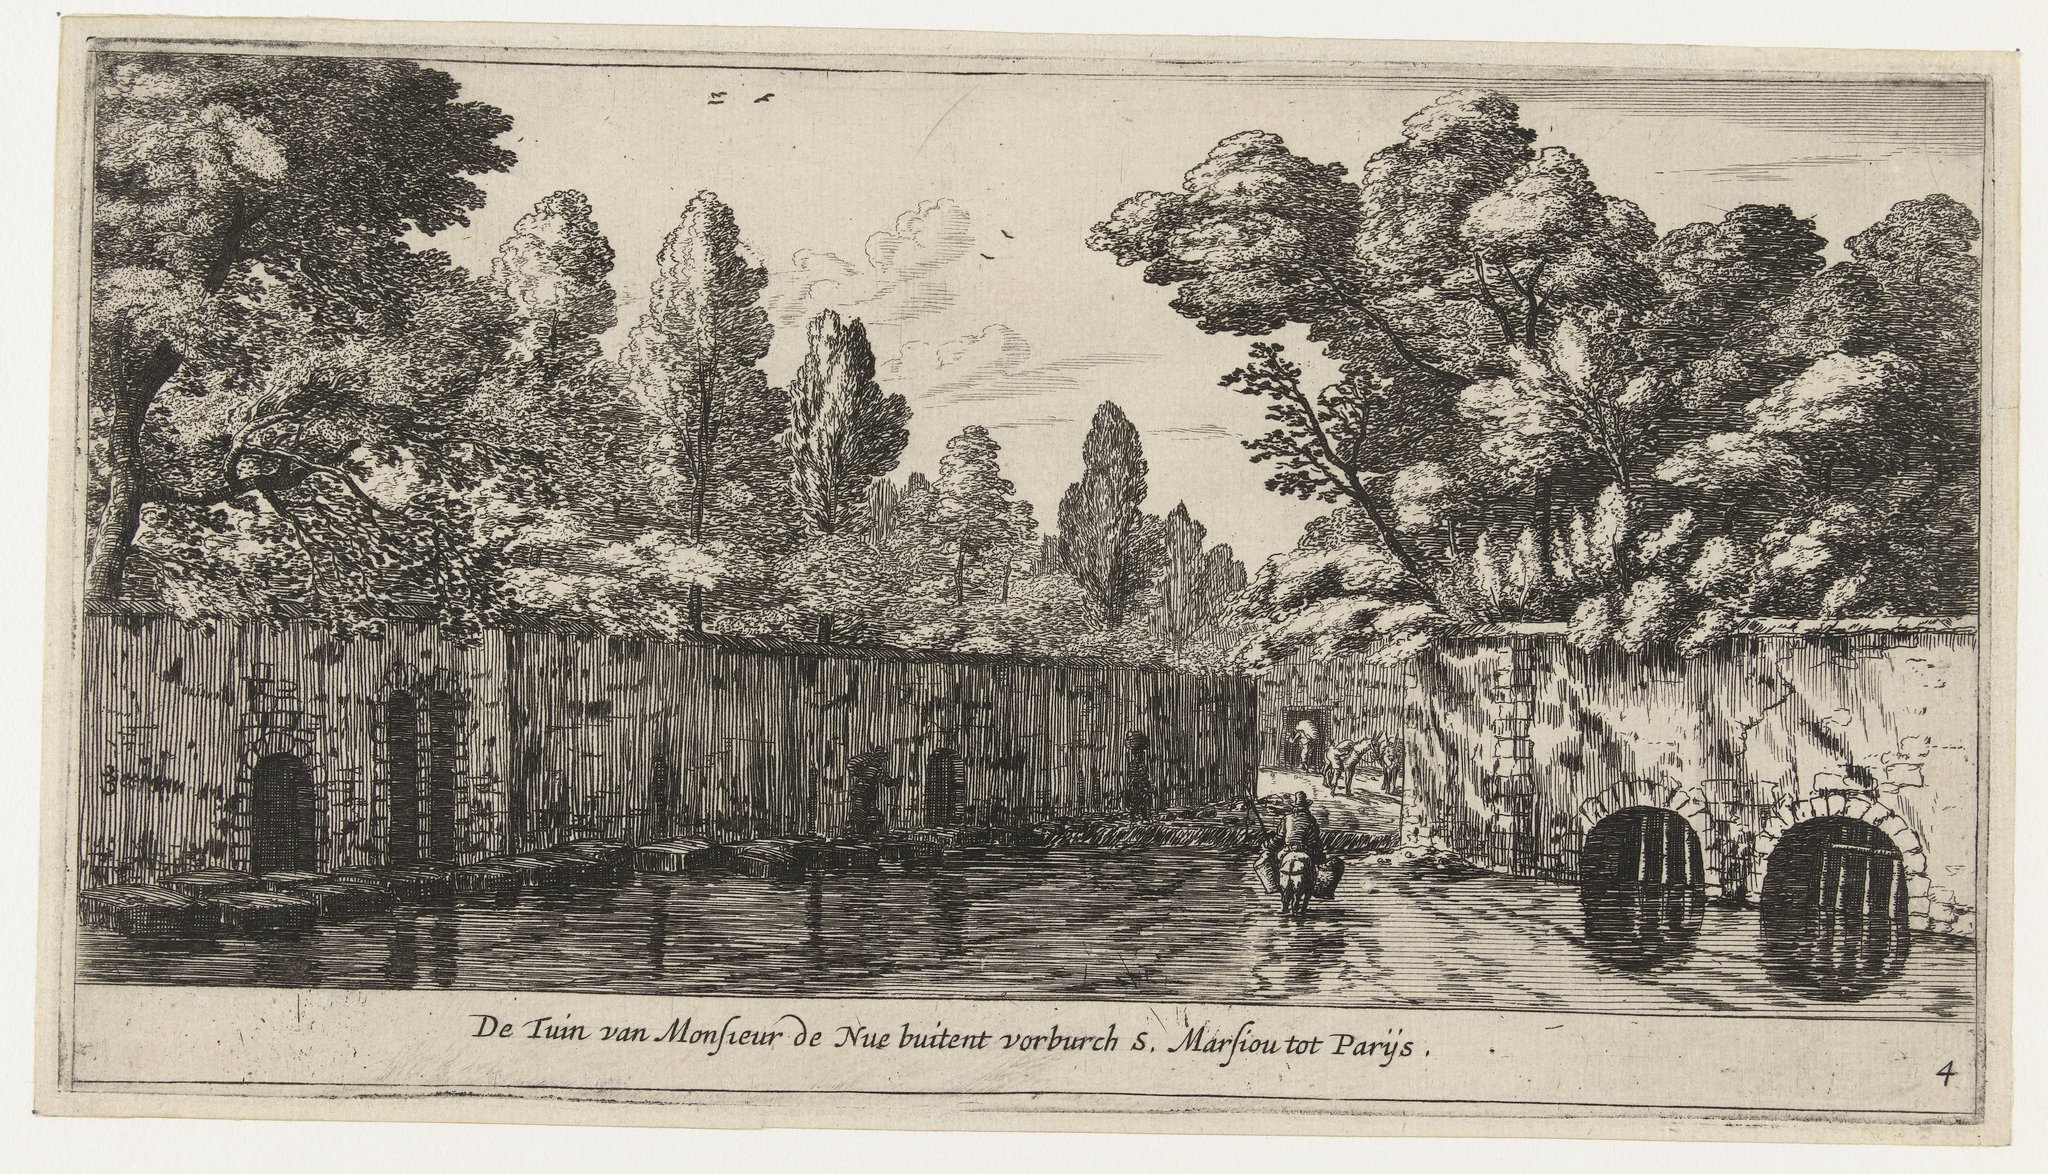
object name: print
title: Gezichten op Parijs en omgeving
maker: reinier nooms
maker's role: draughtsman, painter, print maker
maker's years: 1623-1664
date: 1656-1662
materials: paper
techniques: drypoint, etching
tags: fenced or walled garden; 'hortus conclusus', paris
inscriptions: collector's mark: Lugt 240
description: Ommuurde tuin van Monsieur de Nue buiten de Parijse voorstad Marsiou. Tussen de muren een ondergelopen straat met een aantal mensen.